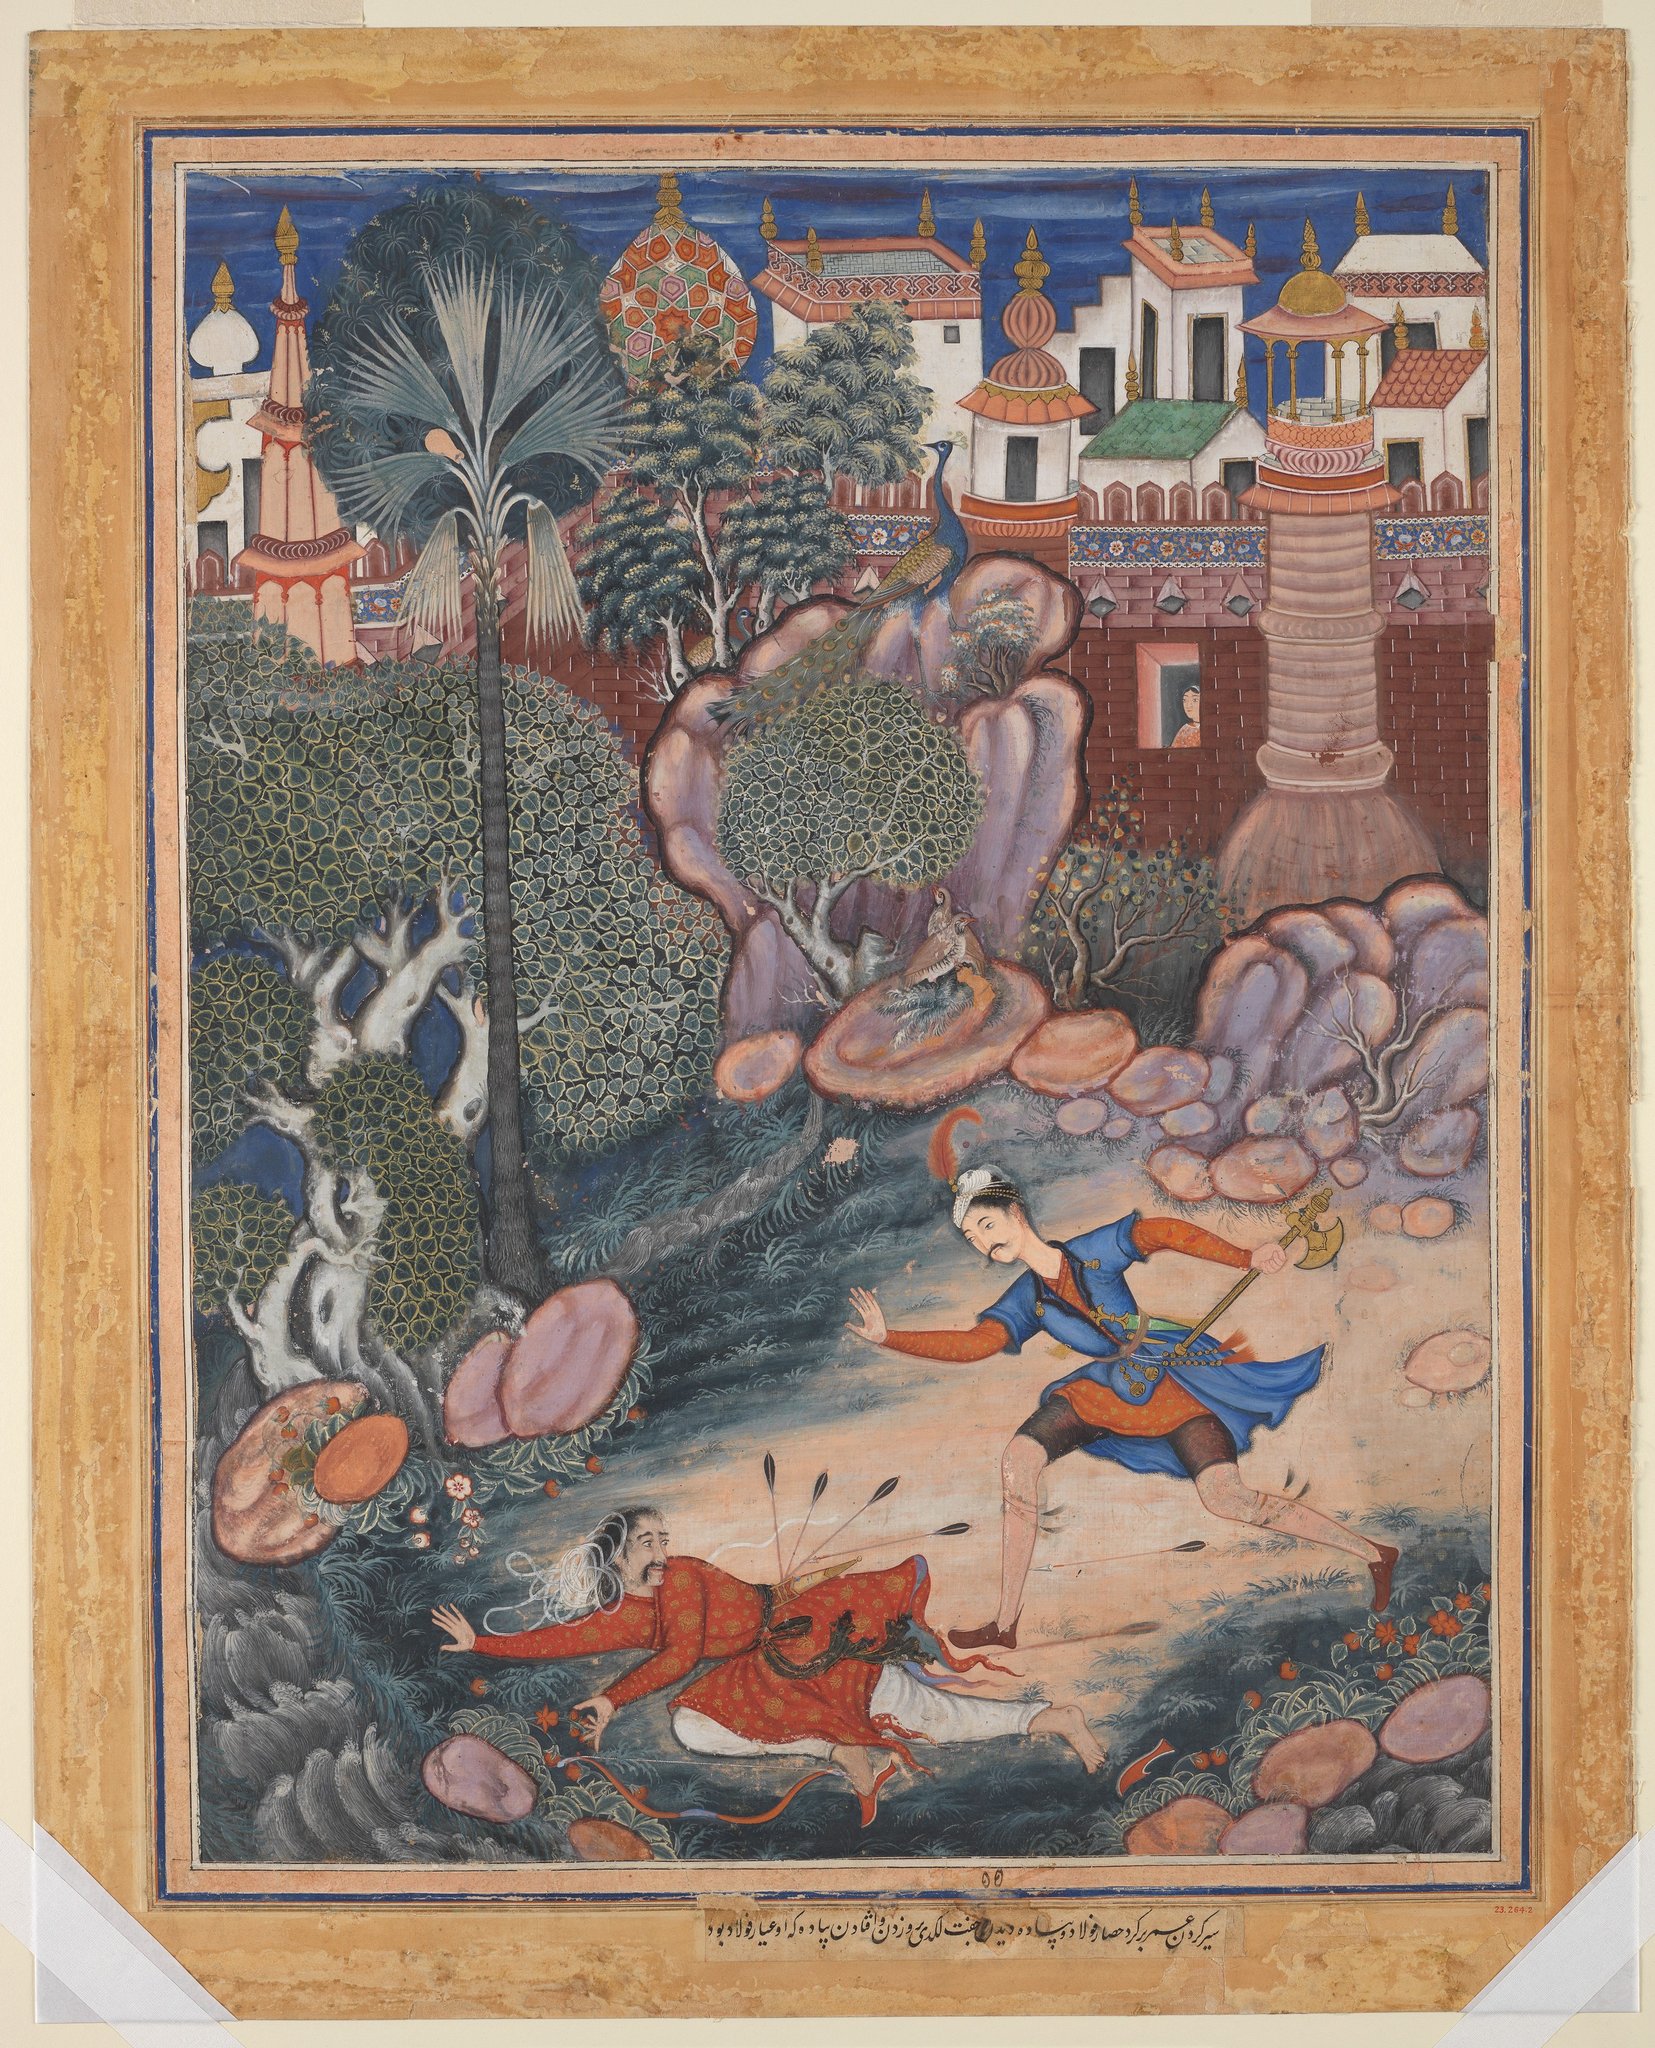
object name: folio from an illustrated manuscript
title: "'Umar Walks around Fulad Castle, Meets a Foot Soldier and Kicks Him to the Ground", Folio from a Hamzanama (The Adventures of Hamza)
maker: kesav das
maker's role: artist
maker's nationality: indian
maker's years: 1545-1630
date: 1570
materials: textile, gold, ink, paper, watercolor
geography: india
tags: castles,soldiers,men,trees